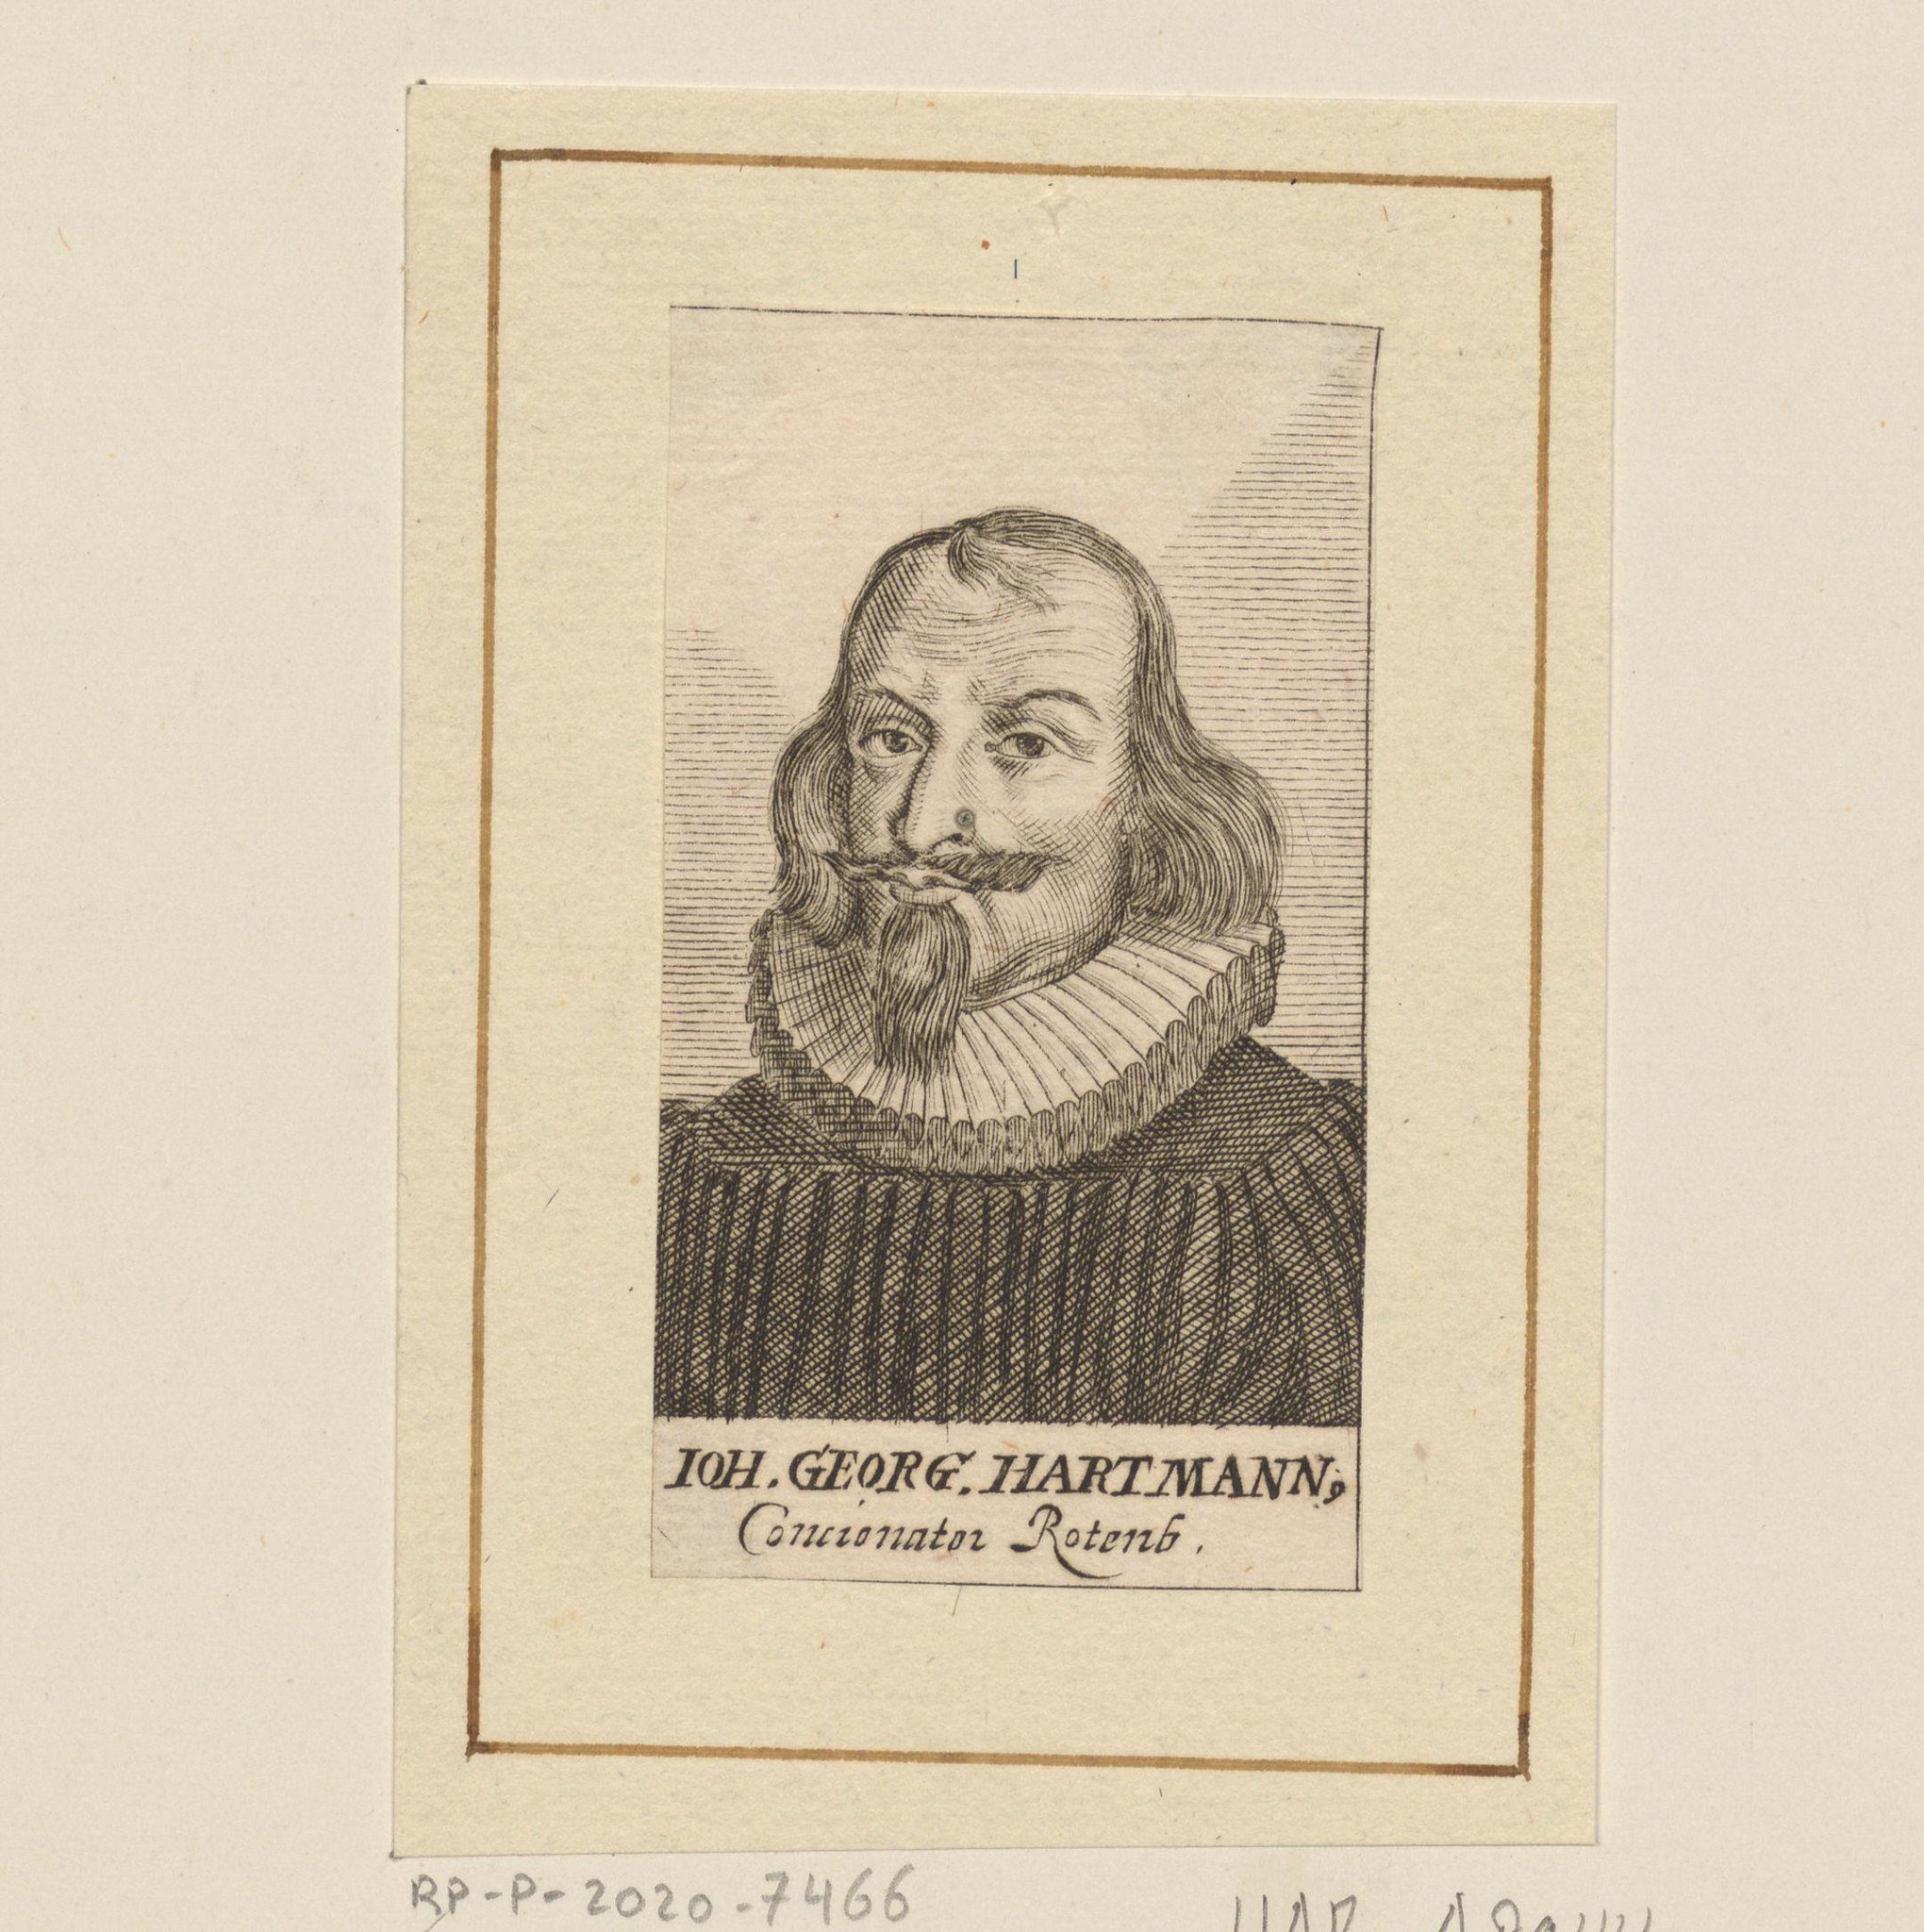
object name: book illustration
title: Portret van Johann Georg I Hartmann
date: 1688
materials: paper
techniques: engraving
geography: nuremberg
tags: theologian, historical persons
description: Prent uit: Freher, Paul. Theatrum virorum eruditione clarorum. Neurenberg: Johann Hoffmann, 1688.